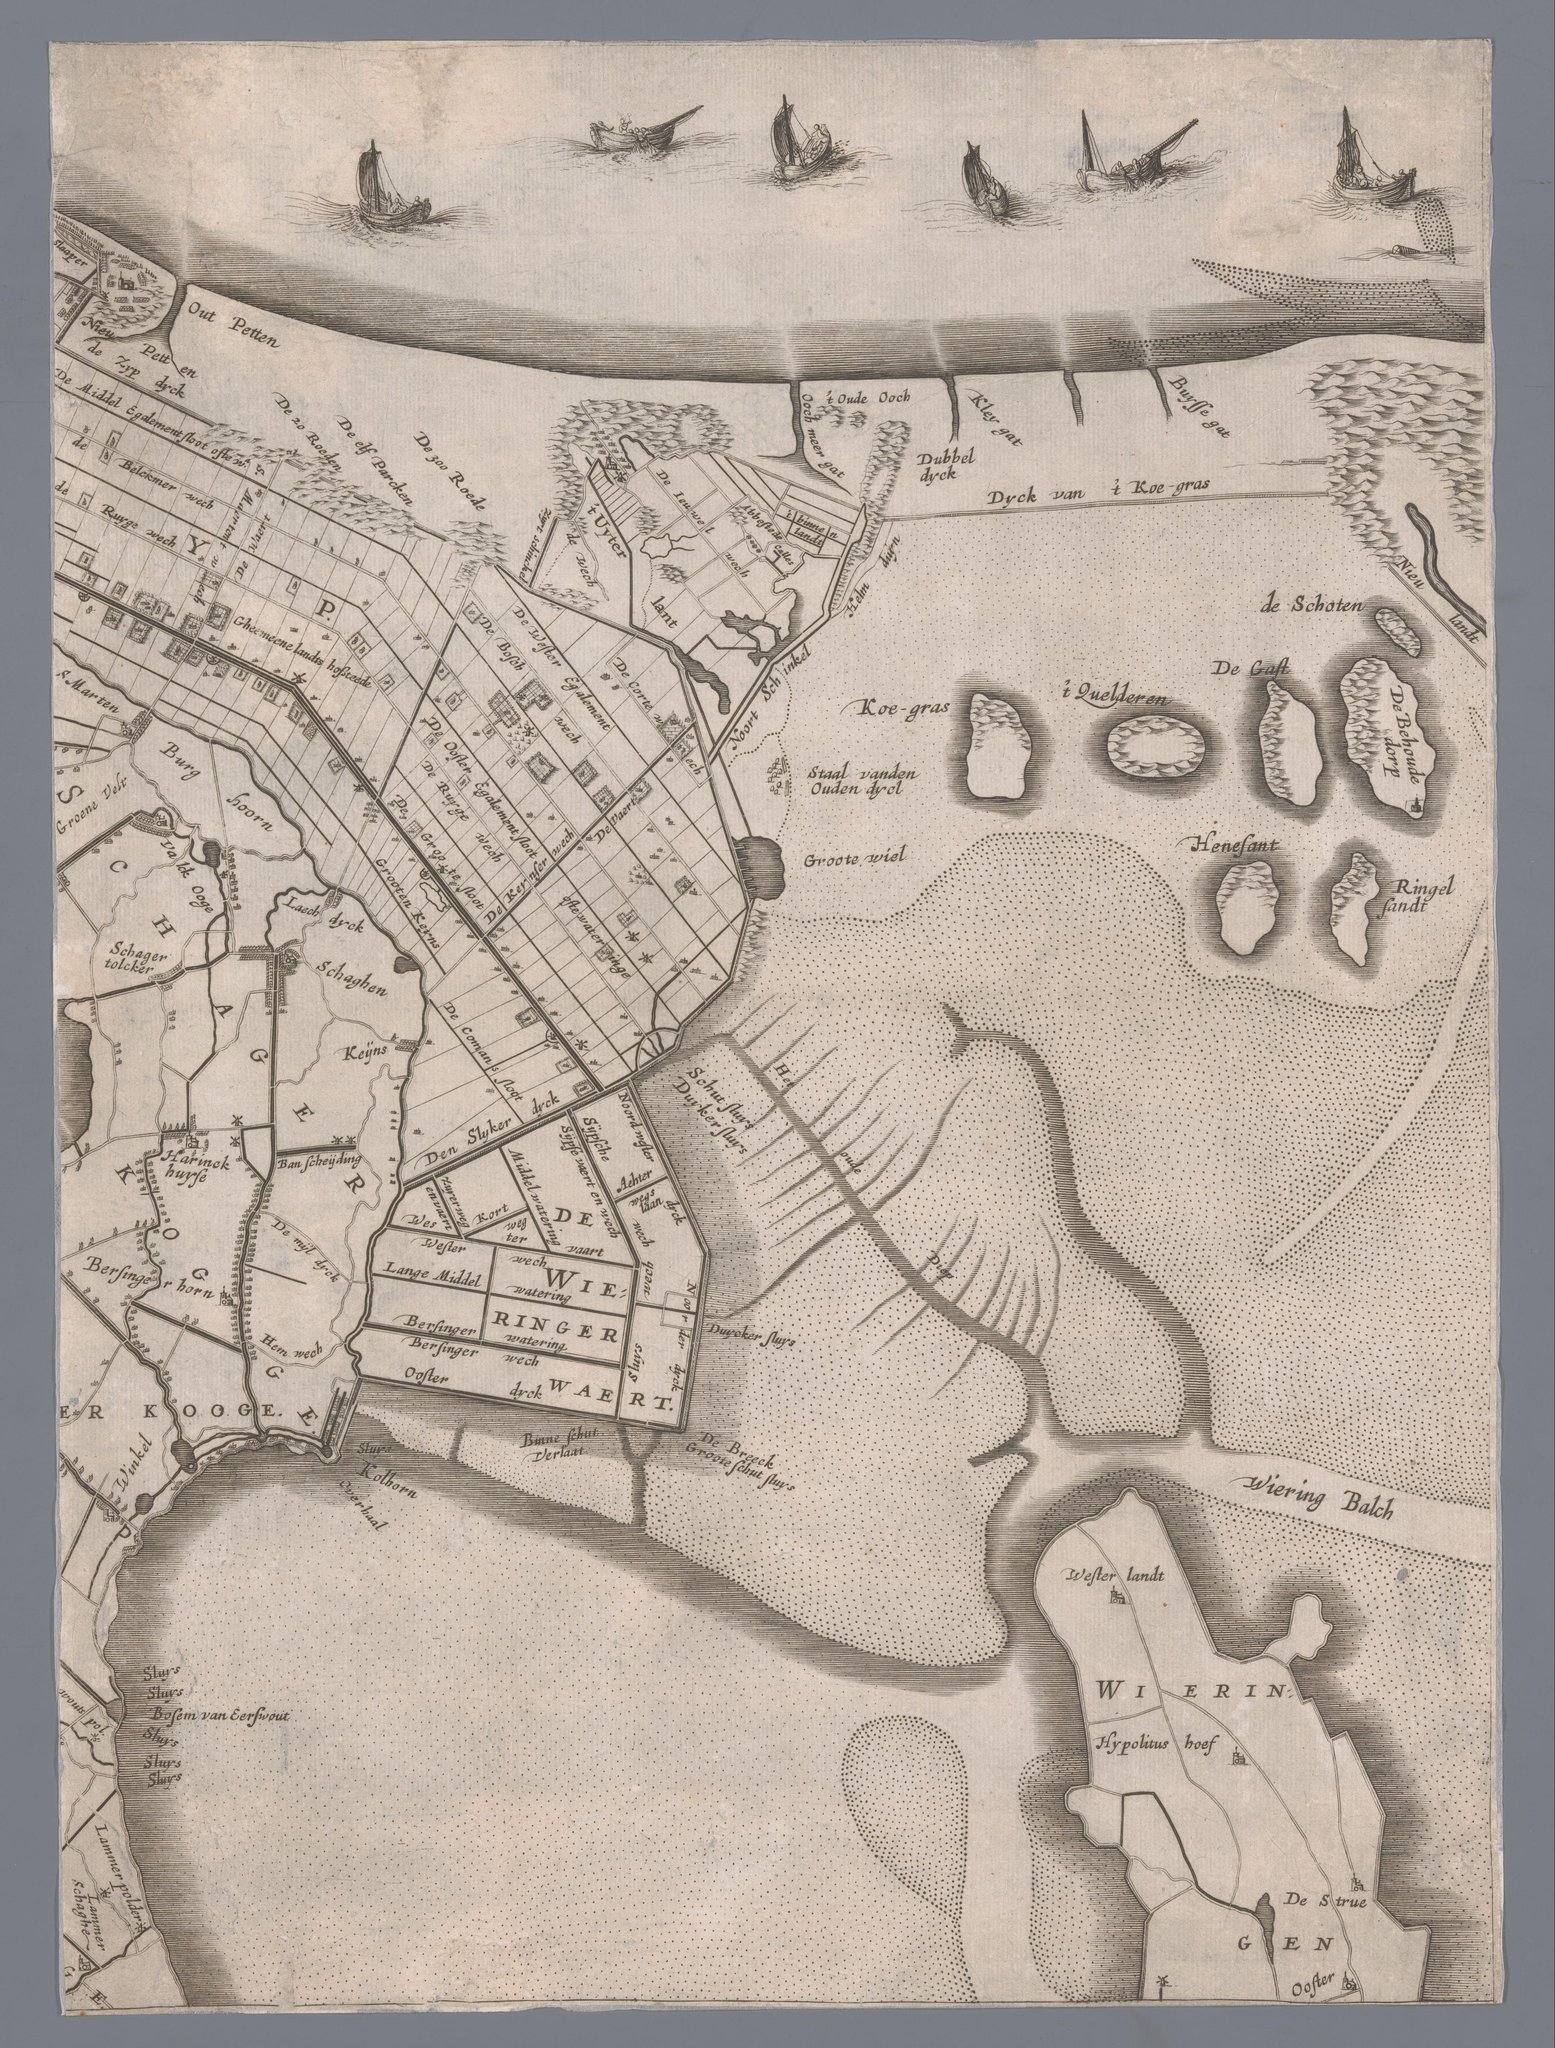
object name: print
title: Kaart van het Graafschap Holland en Utrecht (plaat 18)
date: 1639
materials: paper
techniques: engraving, etching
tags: maps, atlases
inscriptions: collector's mark: Lugt 2228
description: Onderdeel van een kaart samengesteld uit 40 bladen. Waarschijnlijk gaat het om de grootste kaart van Holland uit de zeventiende-eeuw. De kaart is uitgegeven in verschillende edities, deze kaart uit 1639 is de eerste editie.